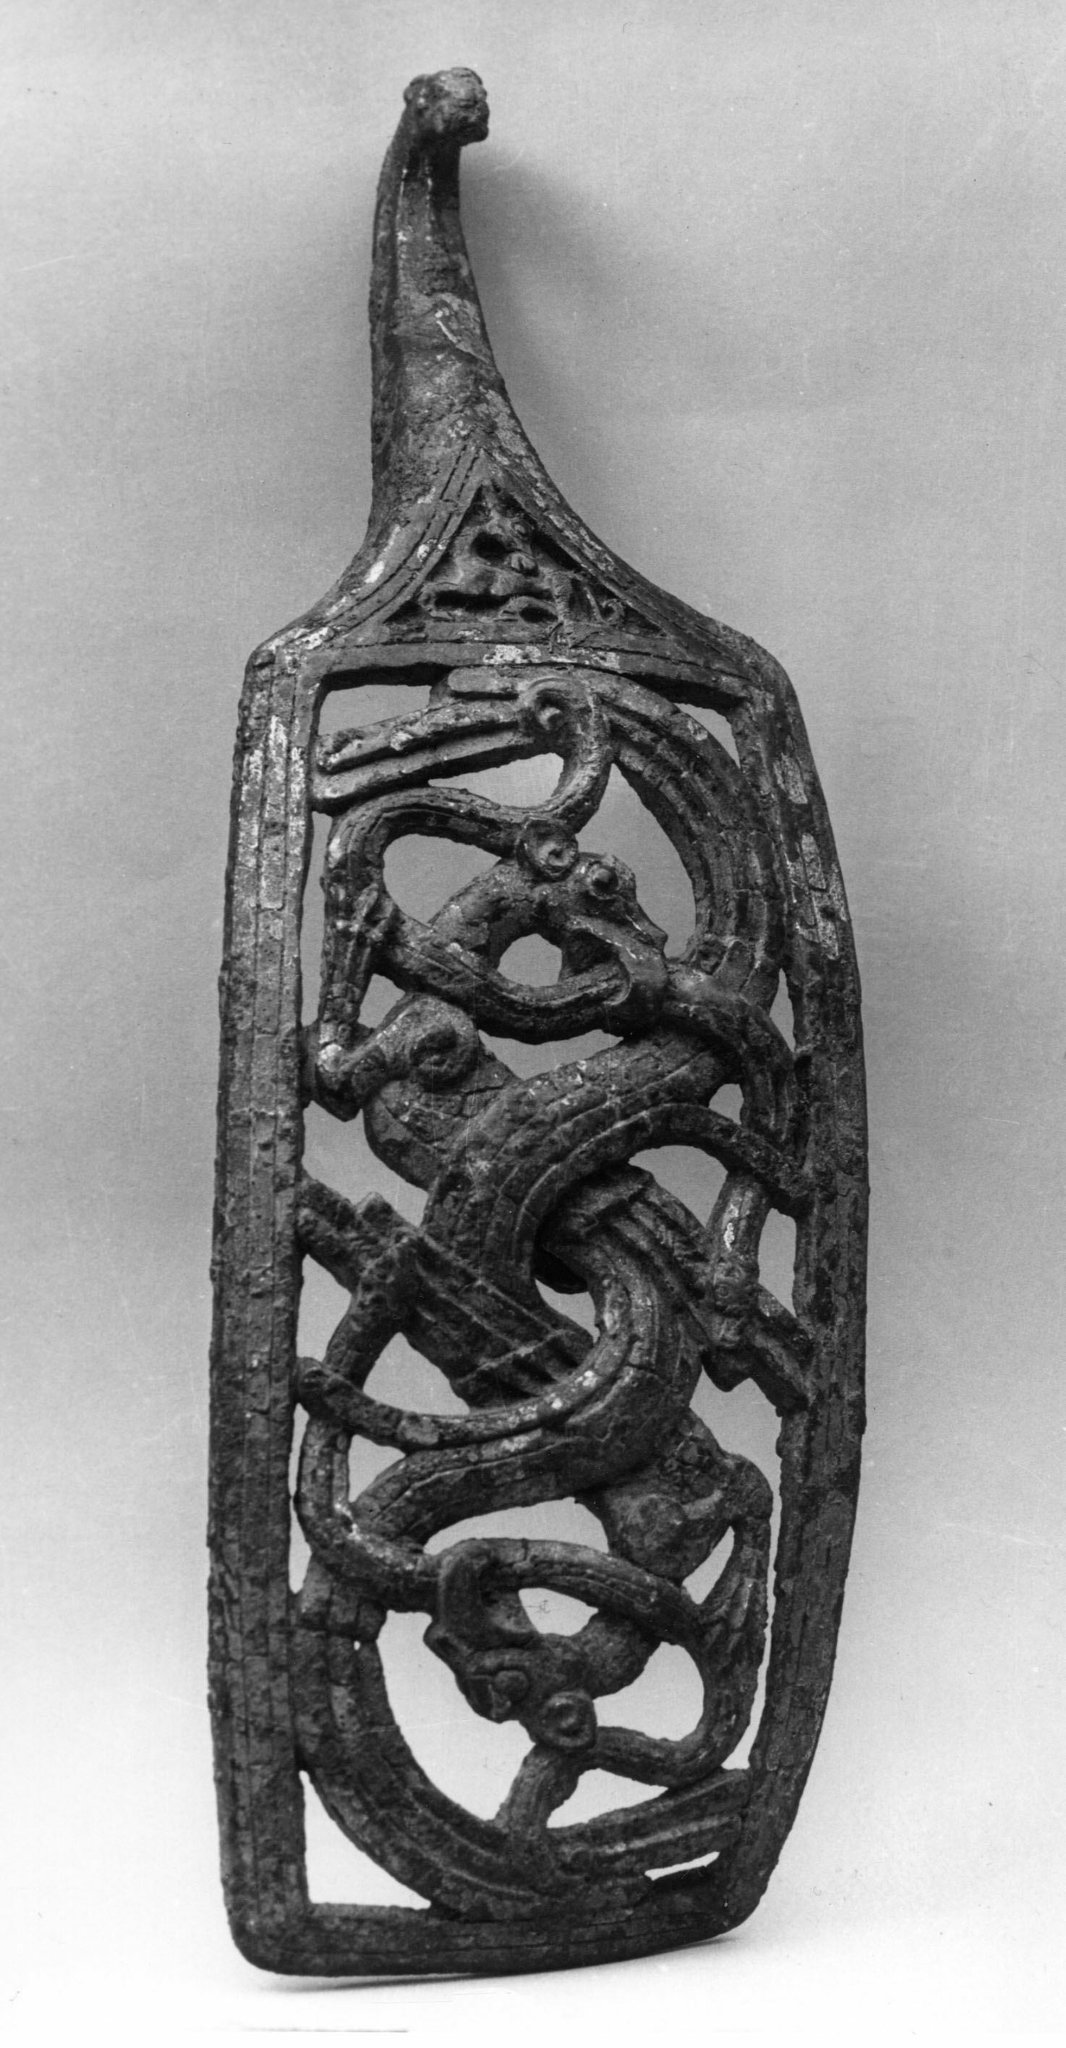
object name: buckle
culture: chinese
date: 206 BCE-220 CE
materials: bronze, lacquer